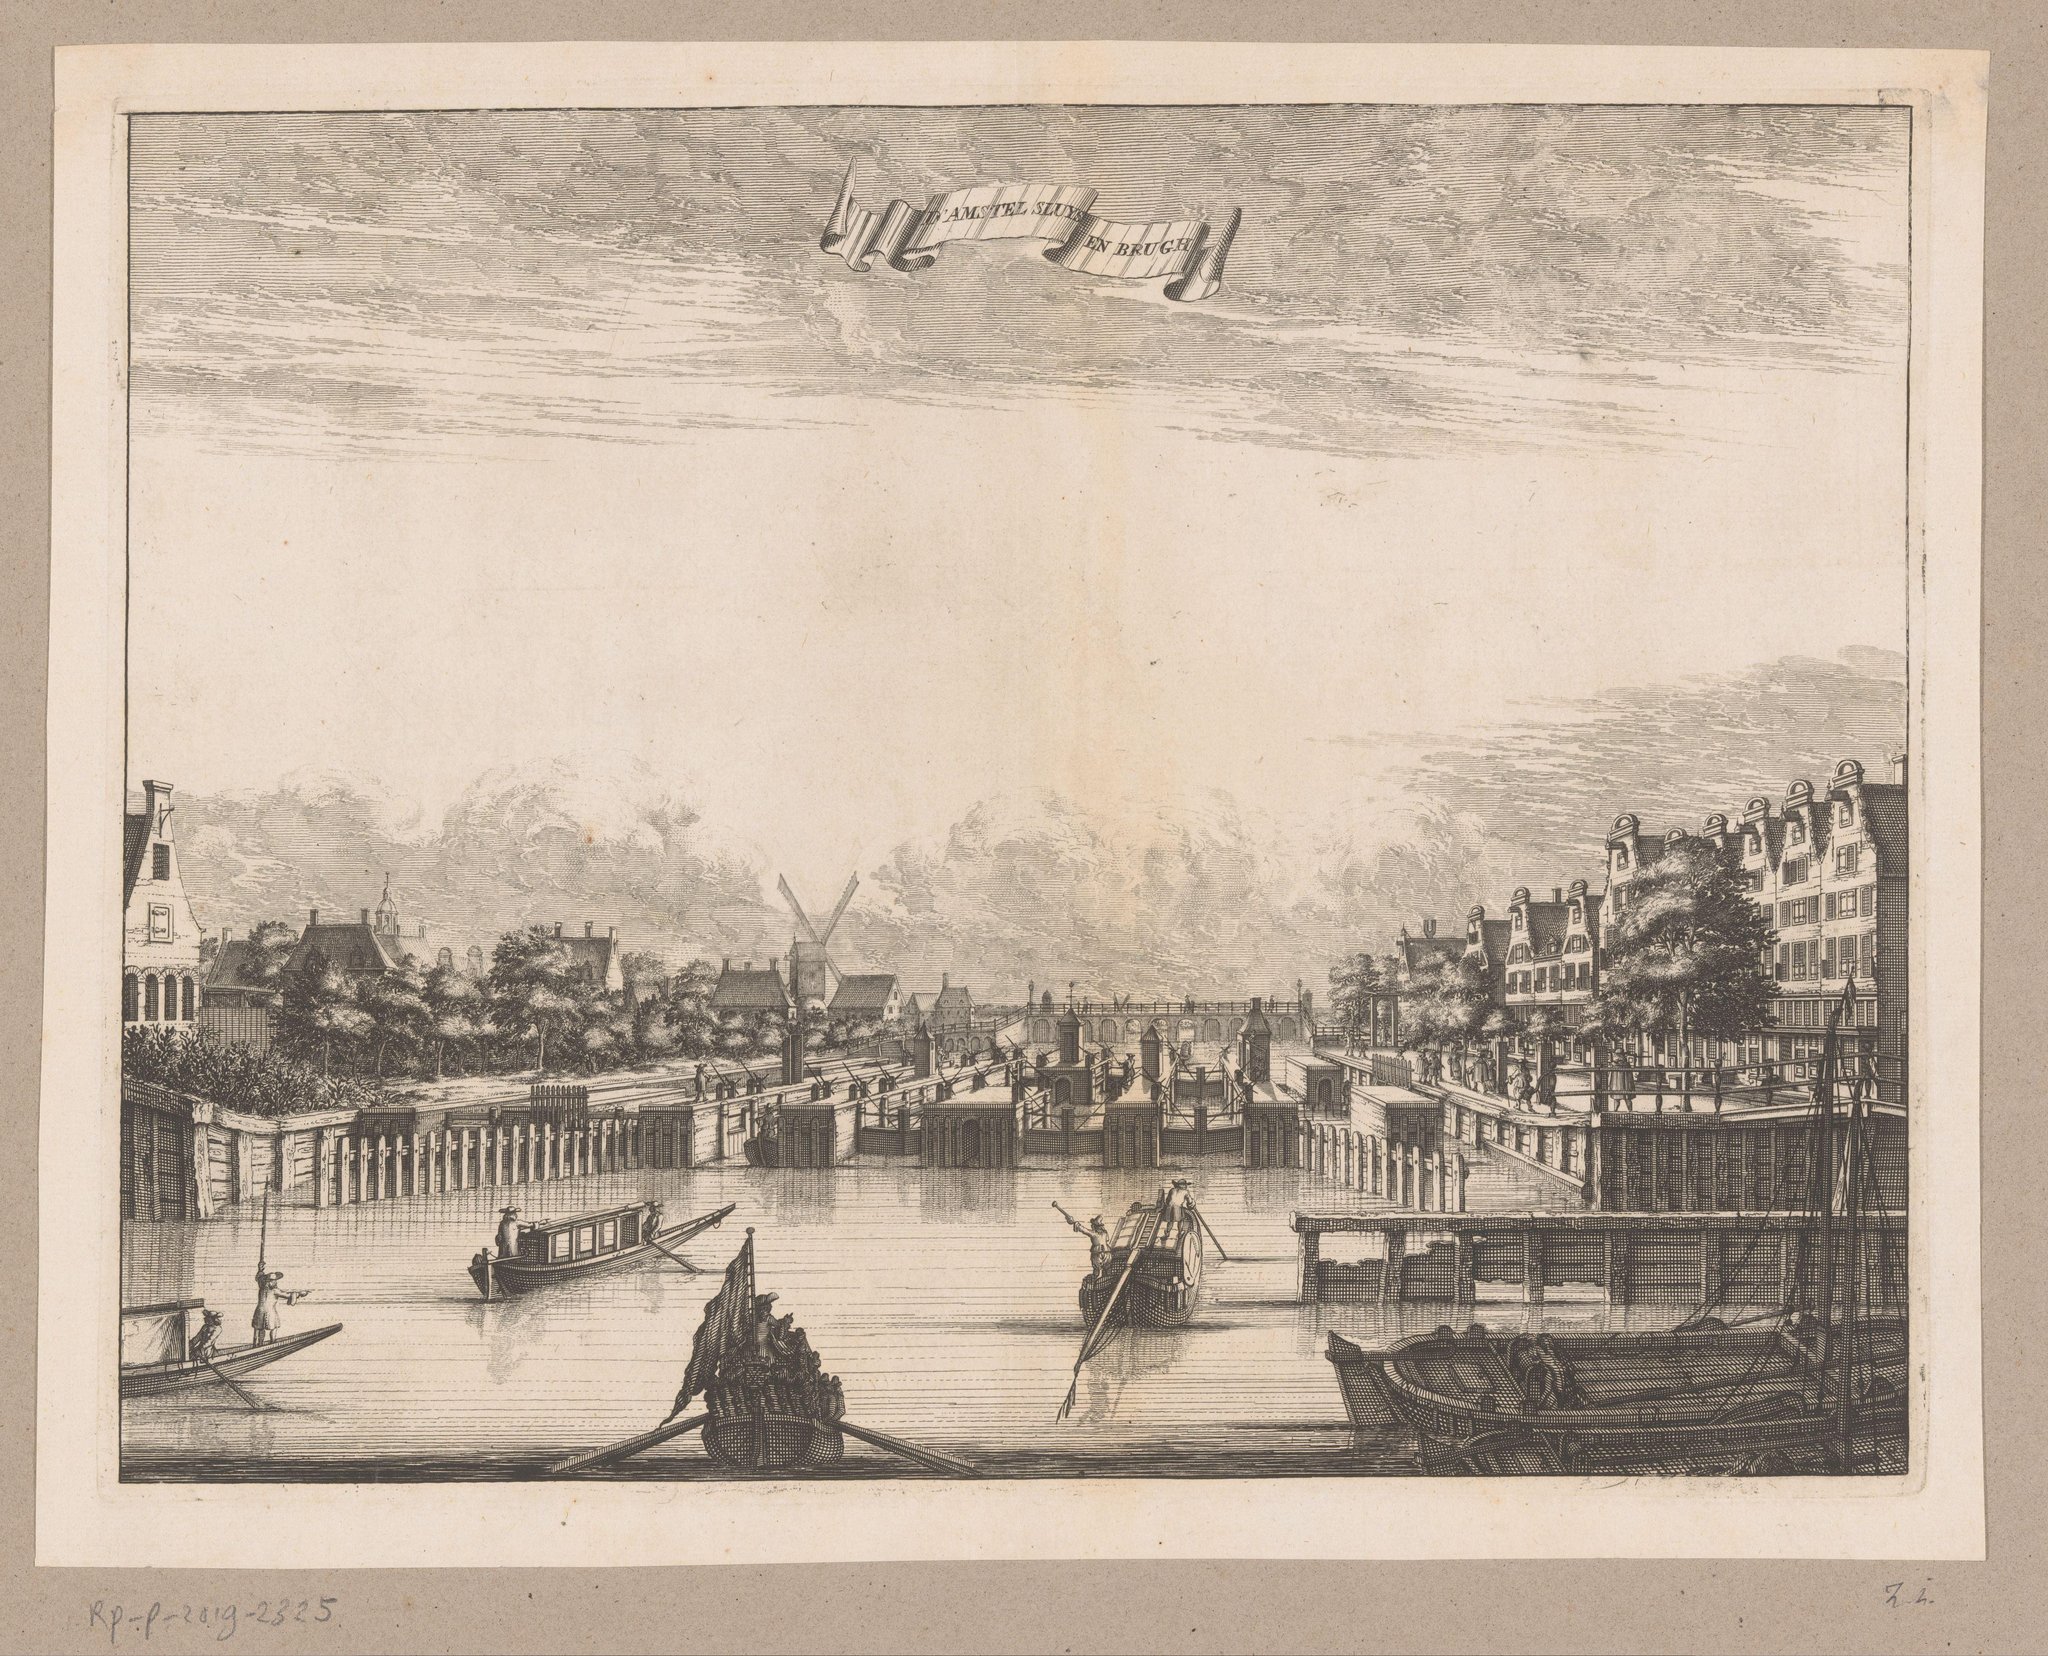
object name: print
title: D'Amstel Sluys en Brugh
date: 1693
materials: paper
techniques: etching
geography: amsterdam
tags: sluice, weir, canals, waters (in city) (+ city(-scape) with figures, staffage)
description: Prent uit: Commelin, Caspar. Beschryvinge van Amsterdam, desselfs eerste oorspronk uyt den Huyse (…). Amsterdam: Abraham Wolfgang et al., 1693, tussen p. 244 en 245. Of uit: Commelin, Caspar. Beschryvinge van Amsterdam, zynde een naukeurige verhandelinge van desselfs eerste oorspronk uyt (…). Amsterdam: weduwe Aart Dircksz Oossaan, 1694. Latere staat gebruikt in: Commelin, Caspar. Beschryvinge van Amsterdam, zynde een naukeurige verhandelinge van desselfs eerste oorspronk uyt (…). Amsterdam: Andries van Damme et al., 1726.